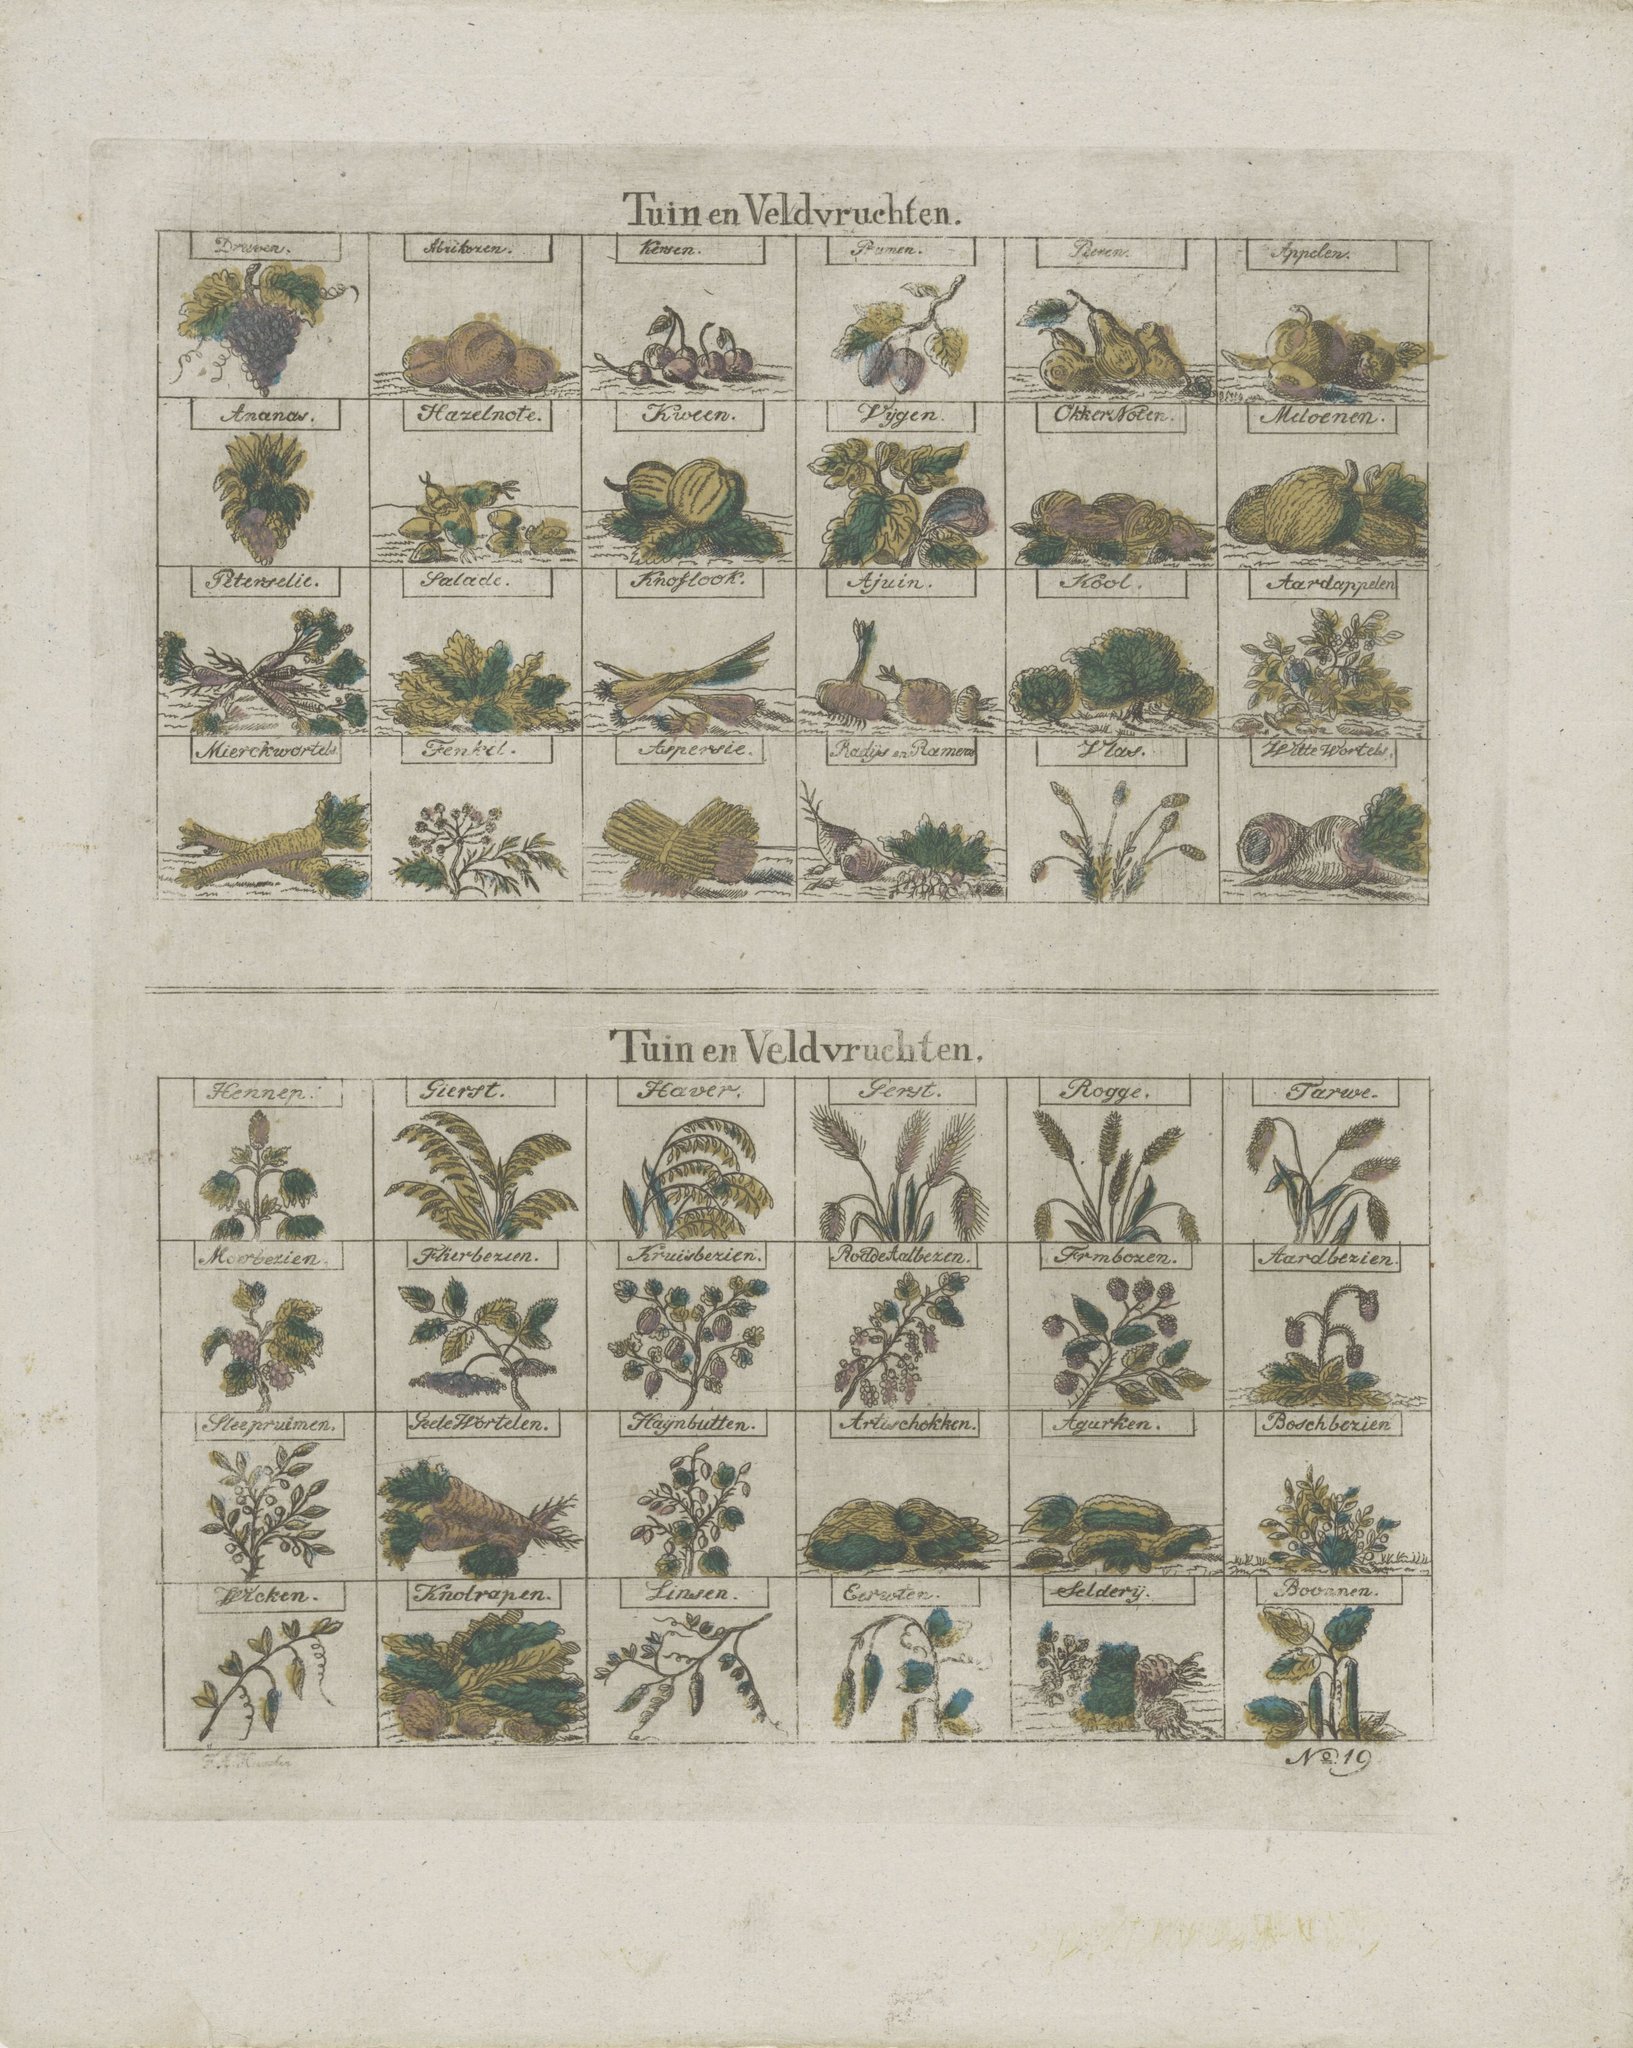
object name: print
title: Tuin en veldvruchten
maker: Anonymous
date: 1700-1899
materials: paper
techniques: colour, etching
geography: netherlands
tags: vegetables, plants; vegetation, fruits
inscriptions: collector's mark: Lugt 2760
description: Blad met 48 voorstellingen van planten, vruchten en groenten. Boven elke voorstelling een titel. Genummerd rechtsonder: No. 19.